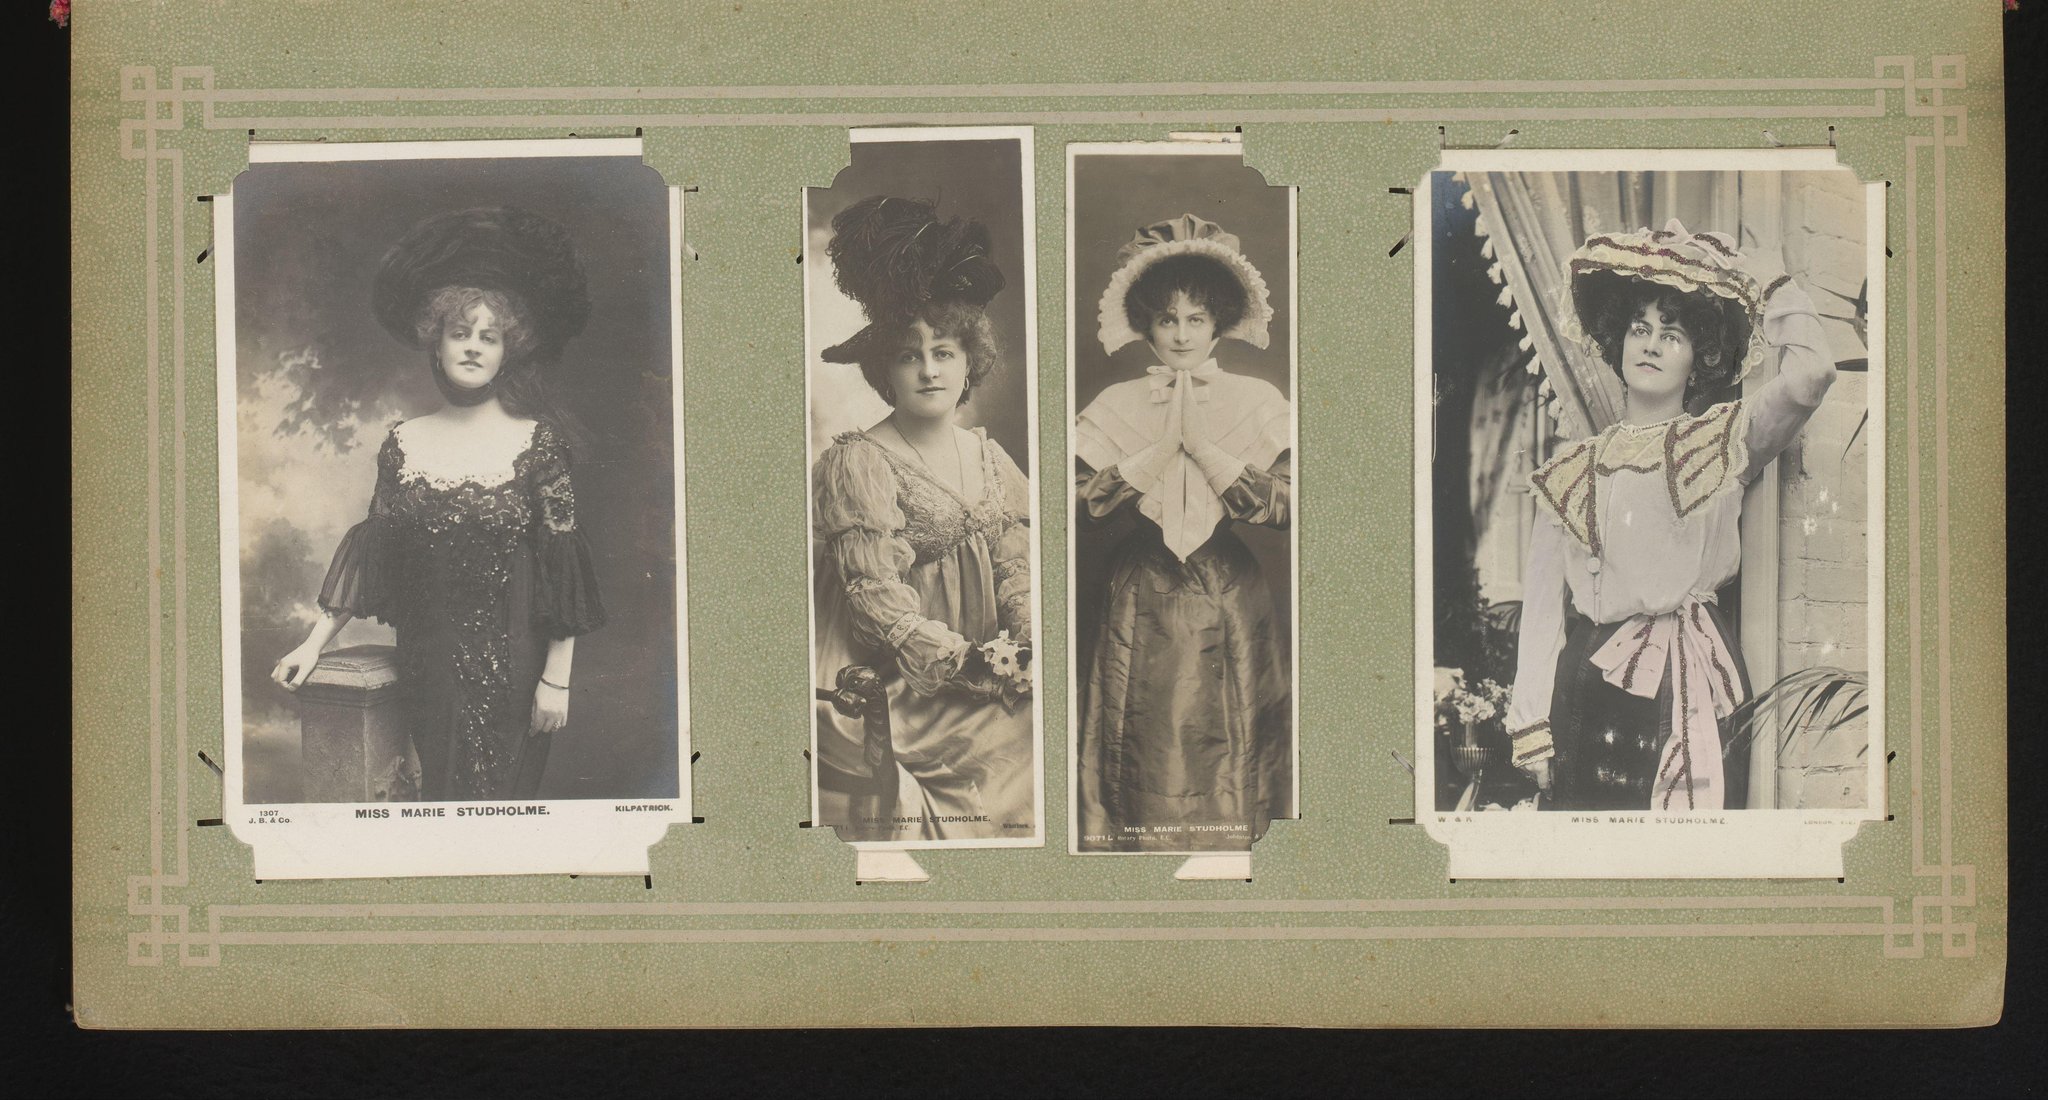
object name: photograph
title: Vier portretten van Marie Studholme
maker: kilpatrick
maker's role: fotograaf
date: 1900-1930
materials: cardboard, photographic support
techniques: gelatin silver print, hand coloring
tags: historical persons - bb - woman, portrait of actor, actress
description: Deze foto's maken deel uit van een album.